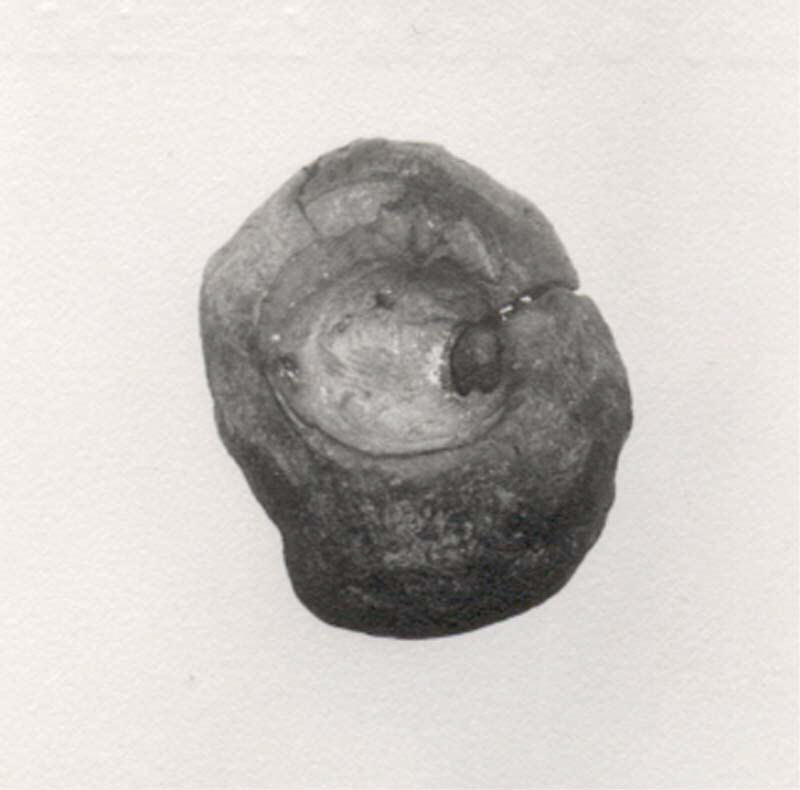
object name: sealing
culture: sasanian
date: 601-700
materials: clay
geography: iran